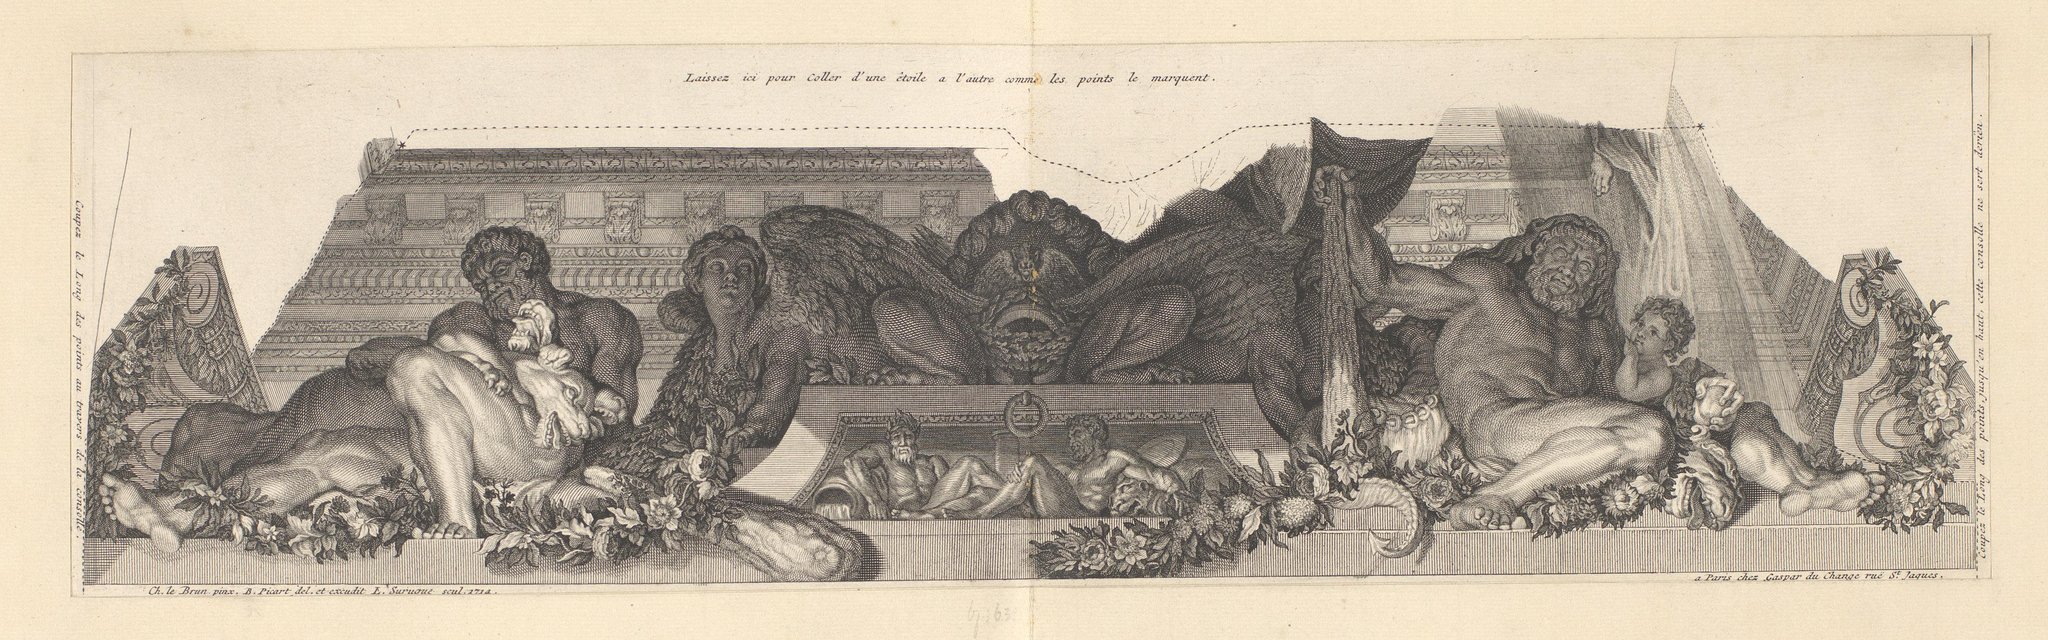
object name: print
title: Galerie Lambert: Apotheose van Hercules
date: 1714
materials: paper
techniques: engraving, etching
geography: amsterdam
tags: sphinx (lion/woman); 'sfinge' (ripa) - aa - female human figure, (2) the hydra of lerna is killed by hercules, (1) hercules chokes the nemean lion with his arms, hydra of lerna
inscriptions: date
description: Tussen de twee beelden van Hercules zitten twee sfinxen. Detail van het plafond Apotheose van Hercules. Deze prent maakt deel uit van een album.